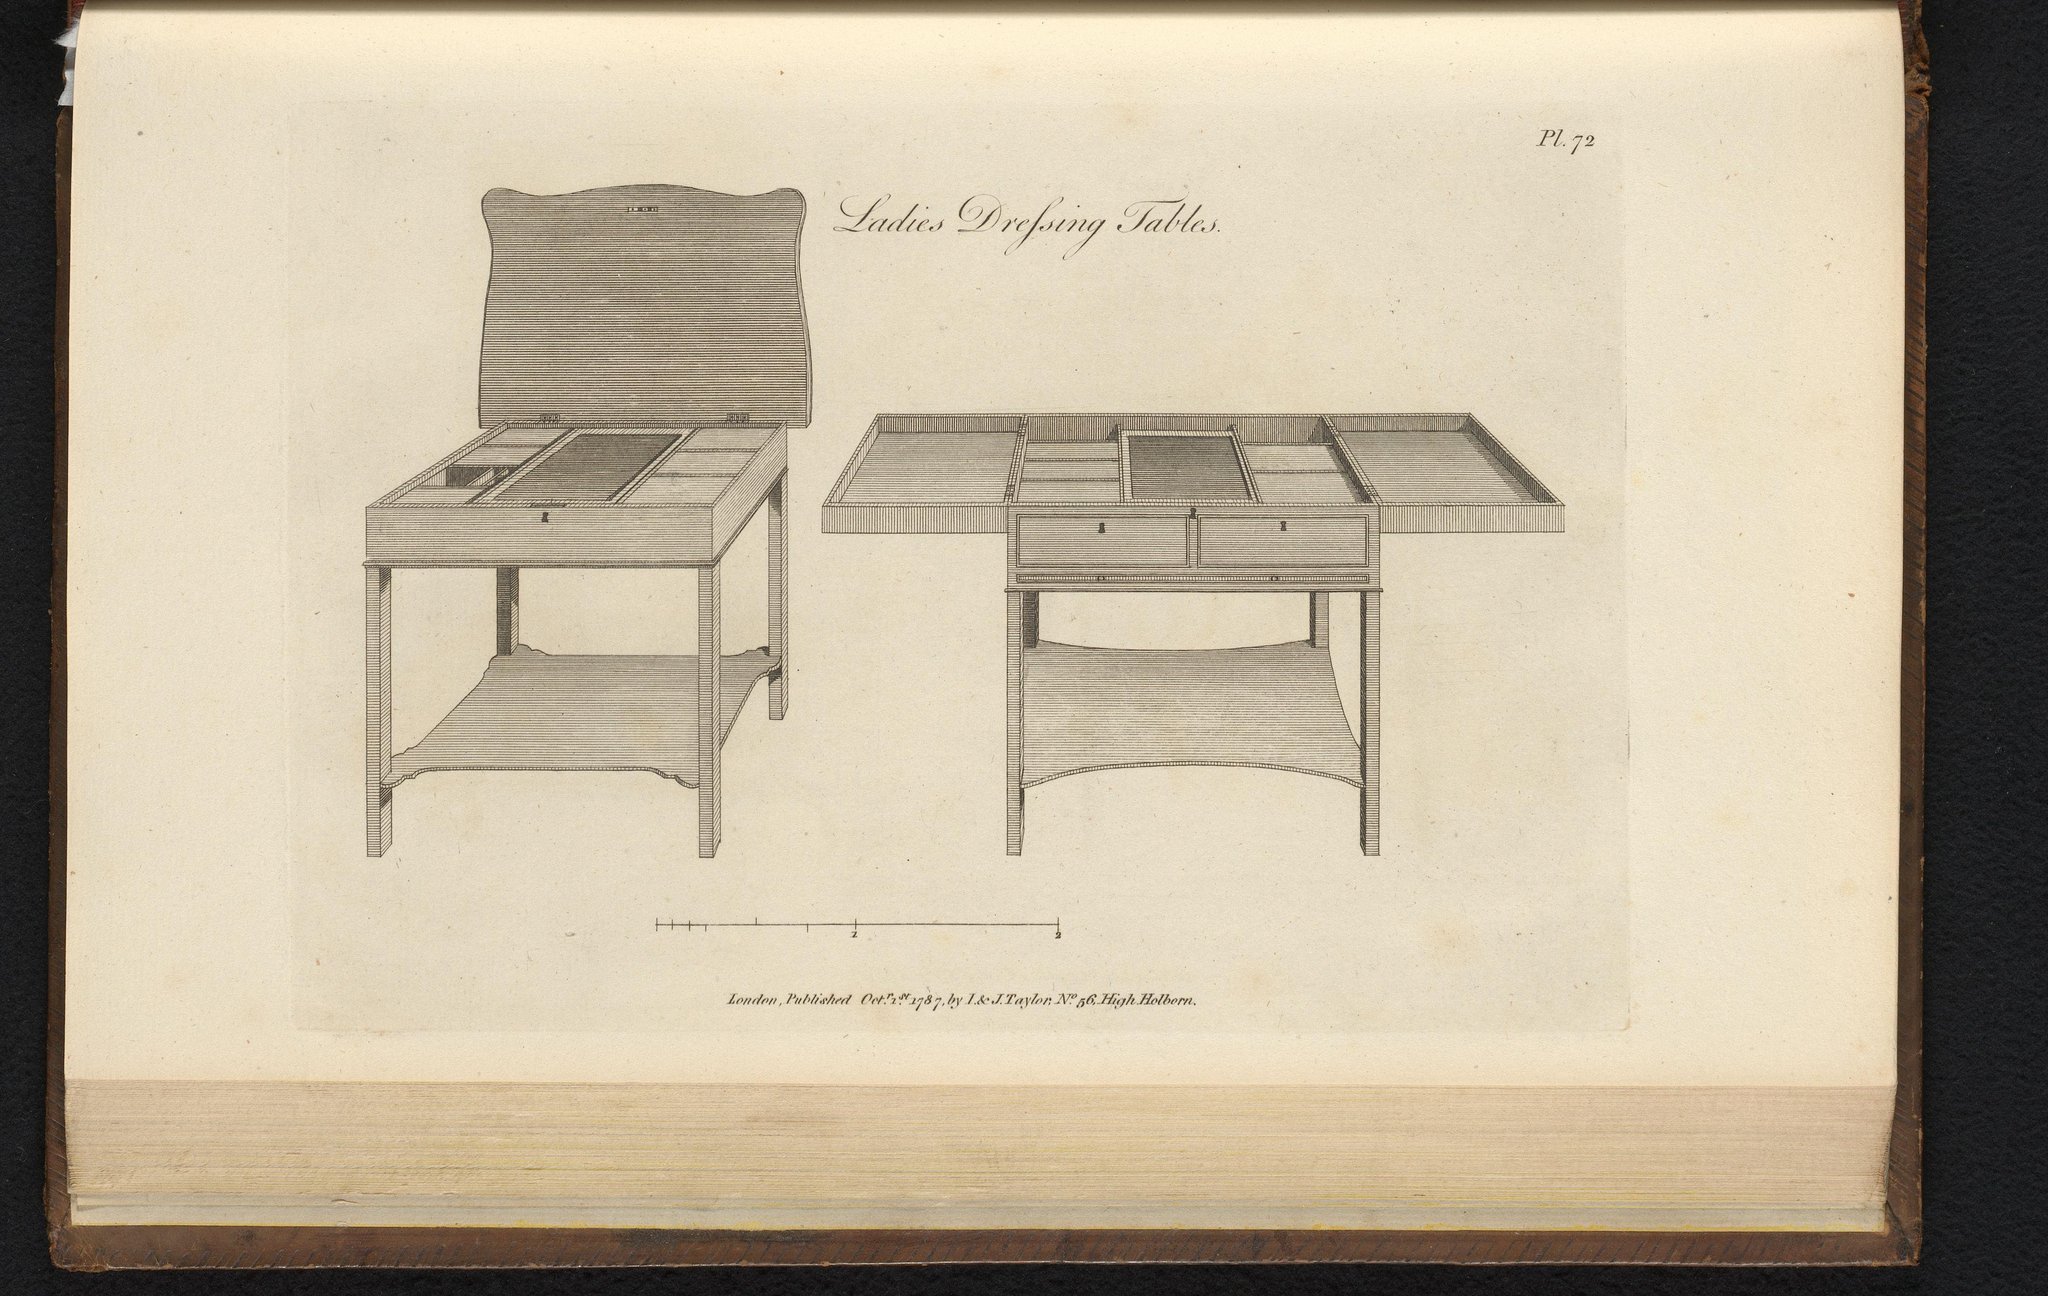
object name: print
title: Meubels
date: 1787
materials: paper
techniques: engraving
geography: holborn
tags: mirror, table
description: Genummerd: Pl. 72. Schaalverdeling in de ondermarge. Prent maakt deel uit van een boek.